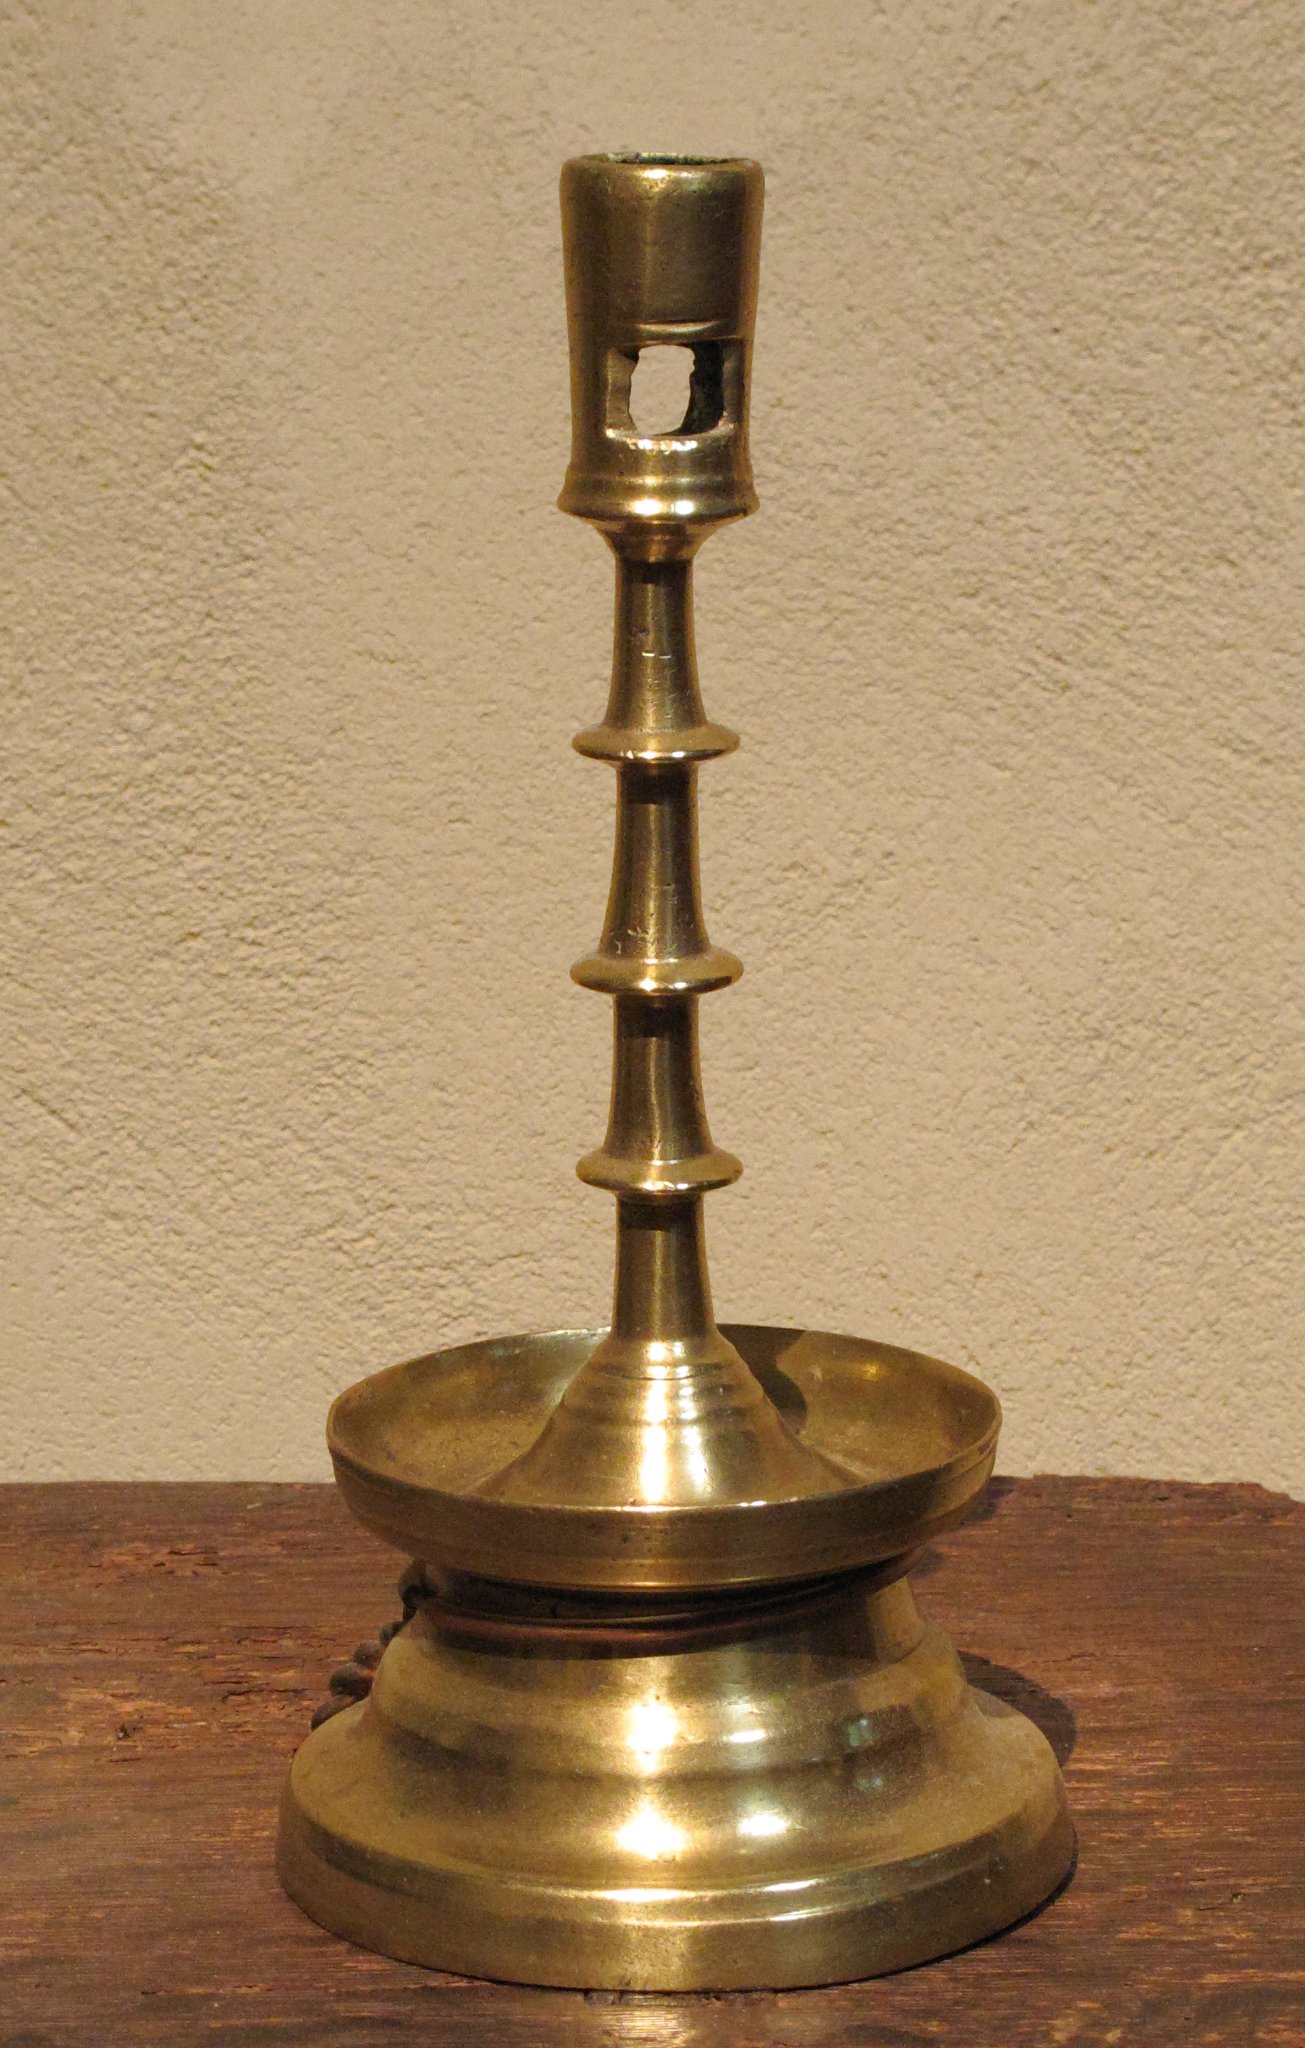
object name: candlestick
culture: german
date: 1401-1500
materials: copper alloy